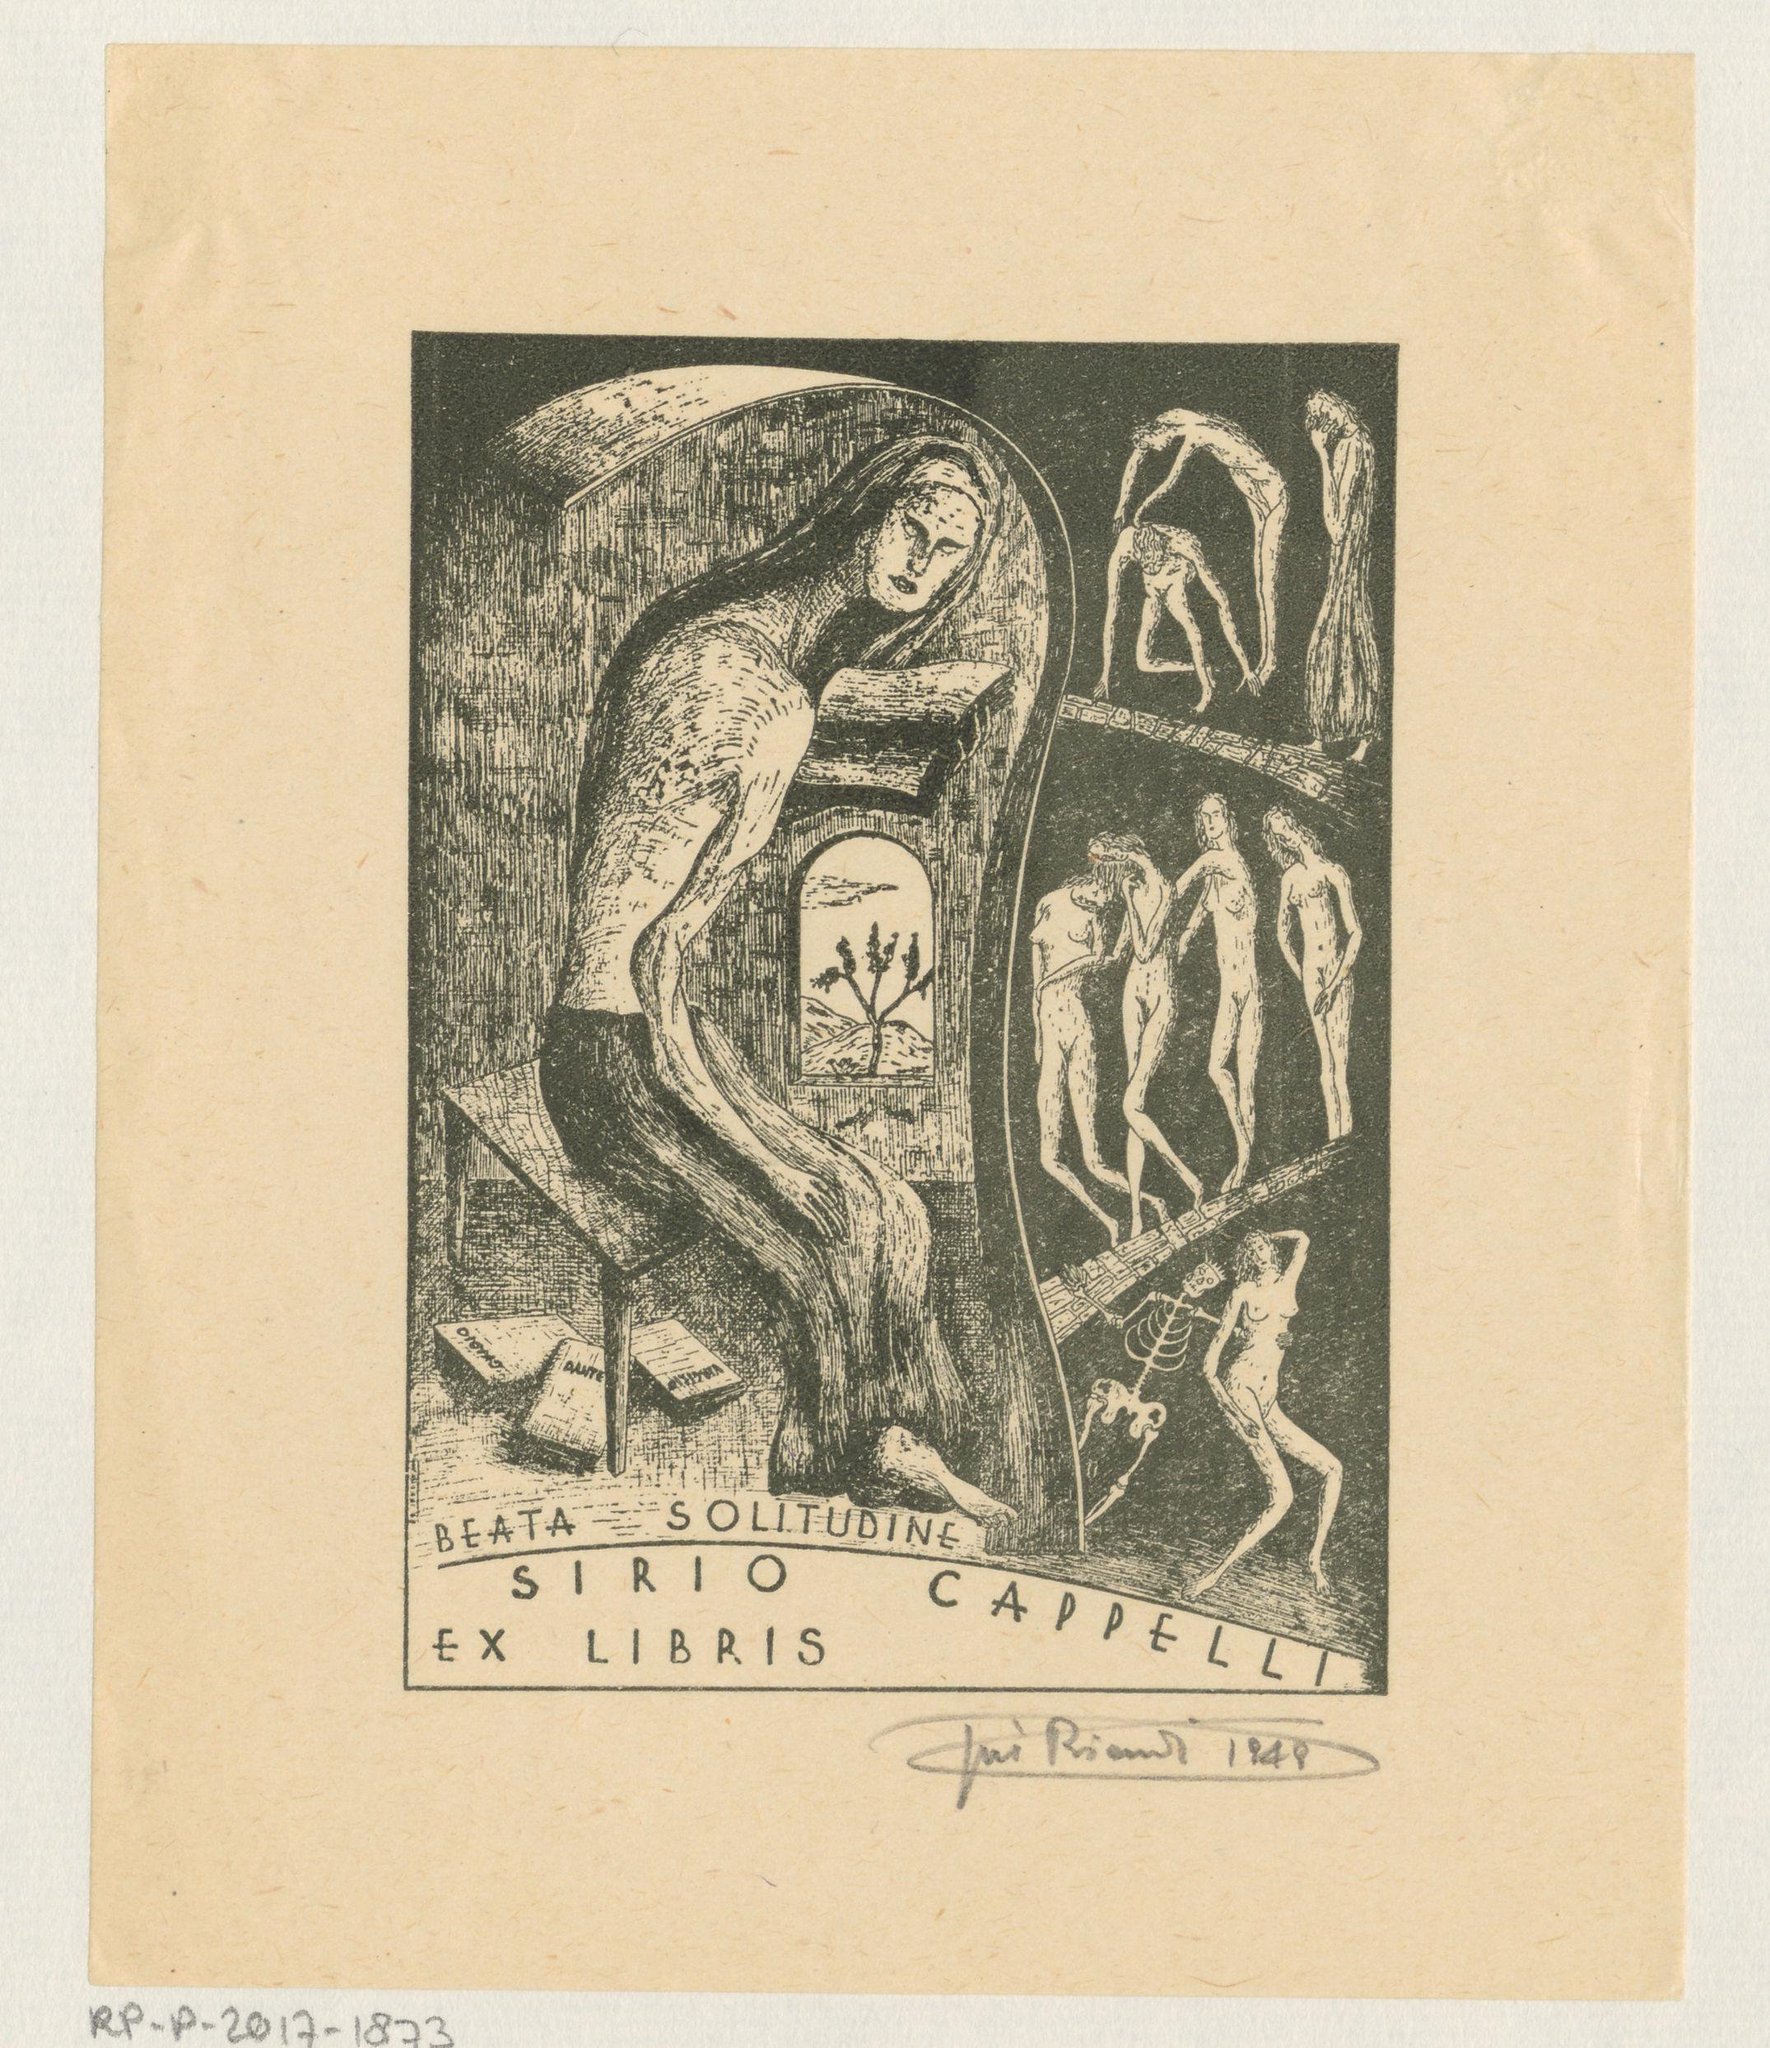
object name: bookplate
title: Beata solitudine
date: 1948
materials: paper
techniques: printing block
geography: italy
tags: sitting figure, view through a window, woman (showing herself) undressed, quasi-nude, book, (human) skeleton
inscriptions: signature and date: ‘Gui Biani (?) 1948’